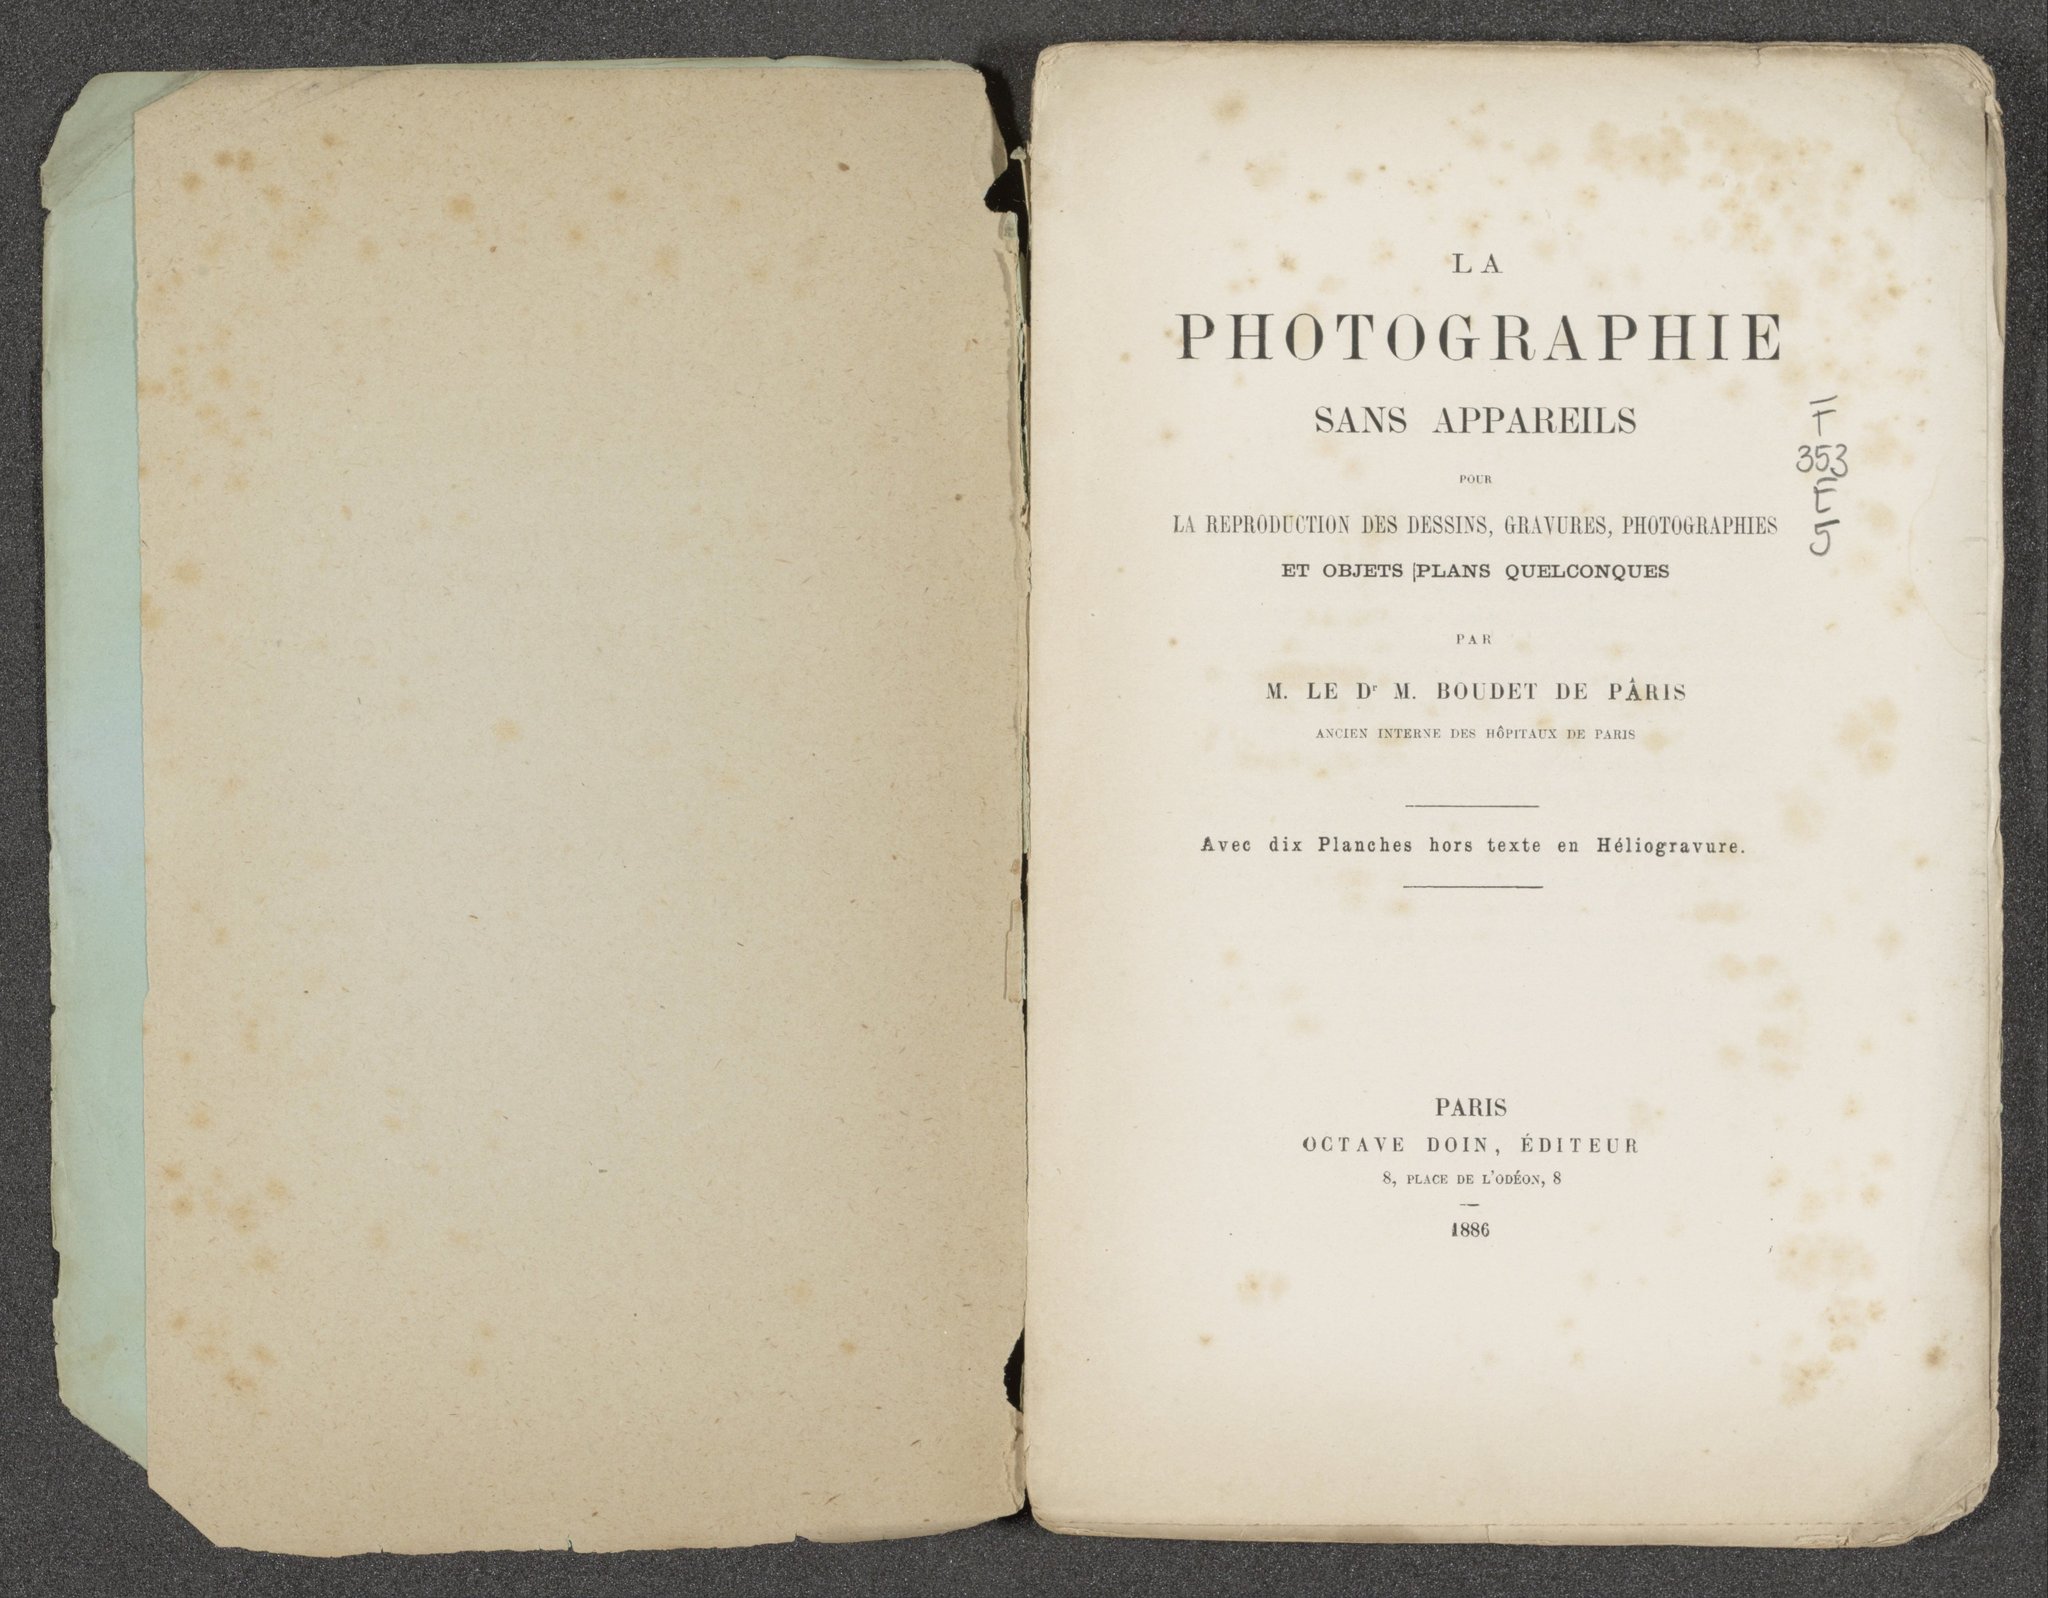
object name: book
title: La photographie sans appareils pour la réproduction des dessins, gravures, photographies et objets plans quelconques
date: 1886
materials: paper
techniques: photoaquatint, printing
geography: paris